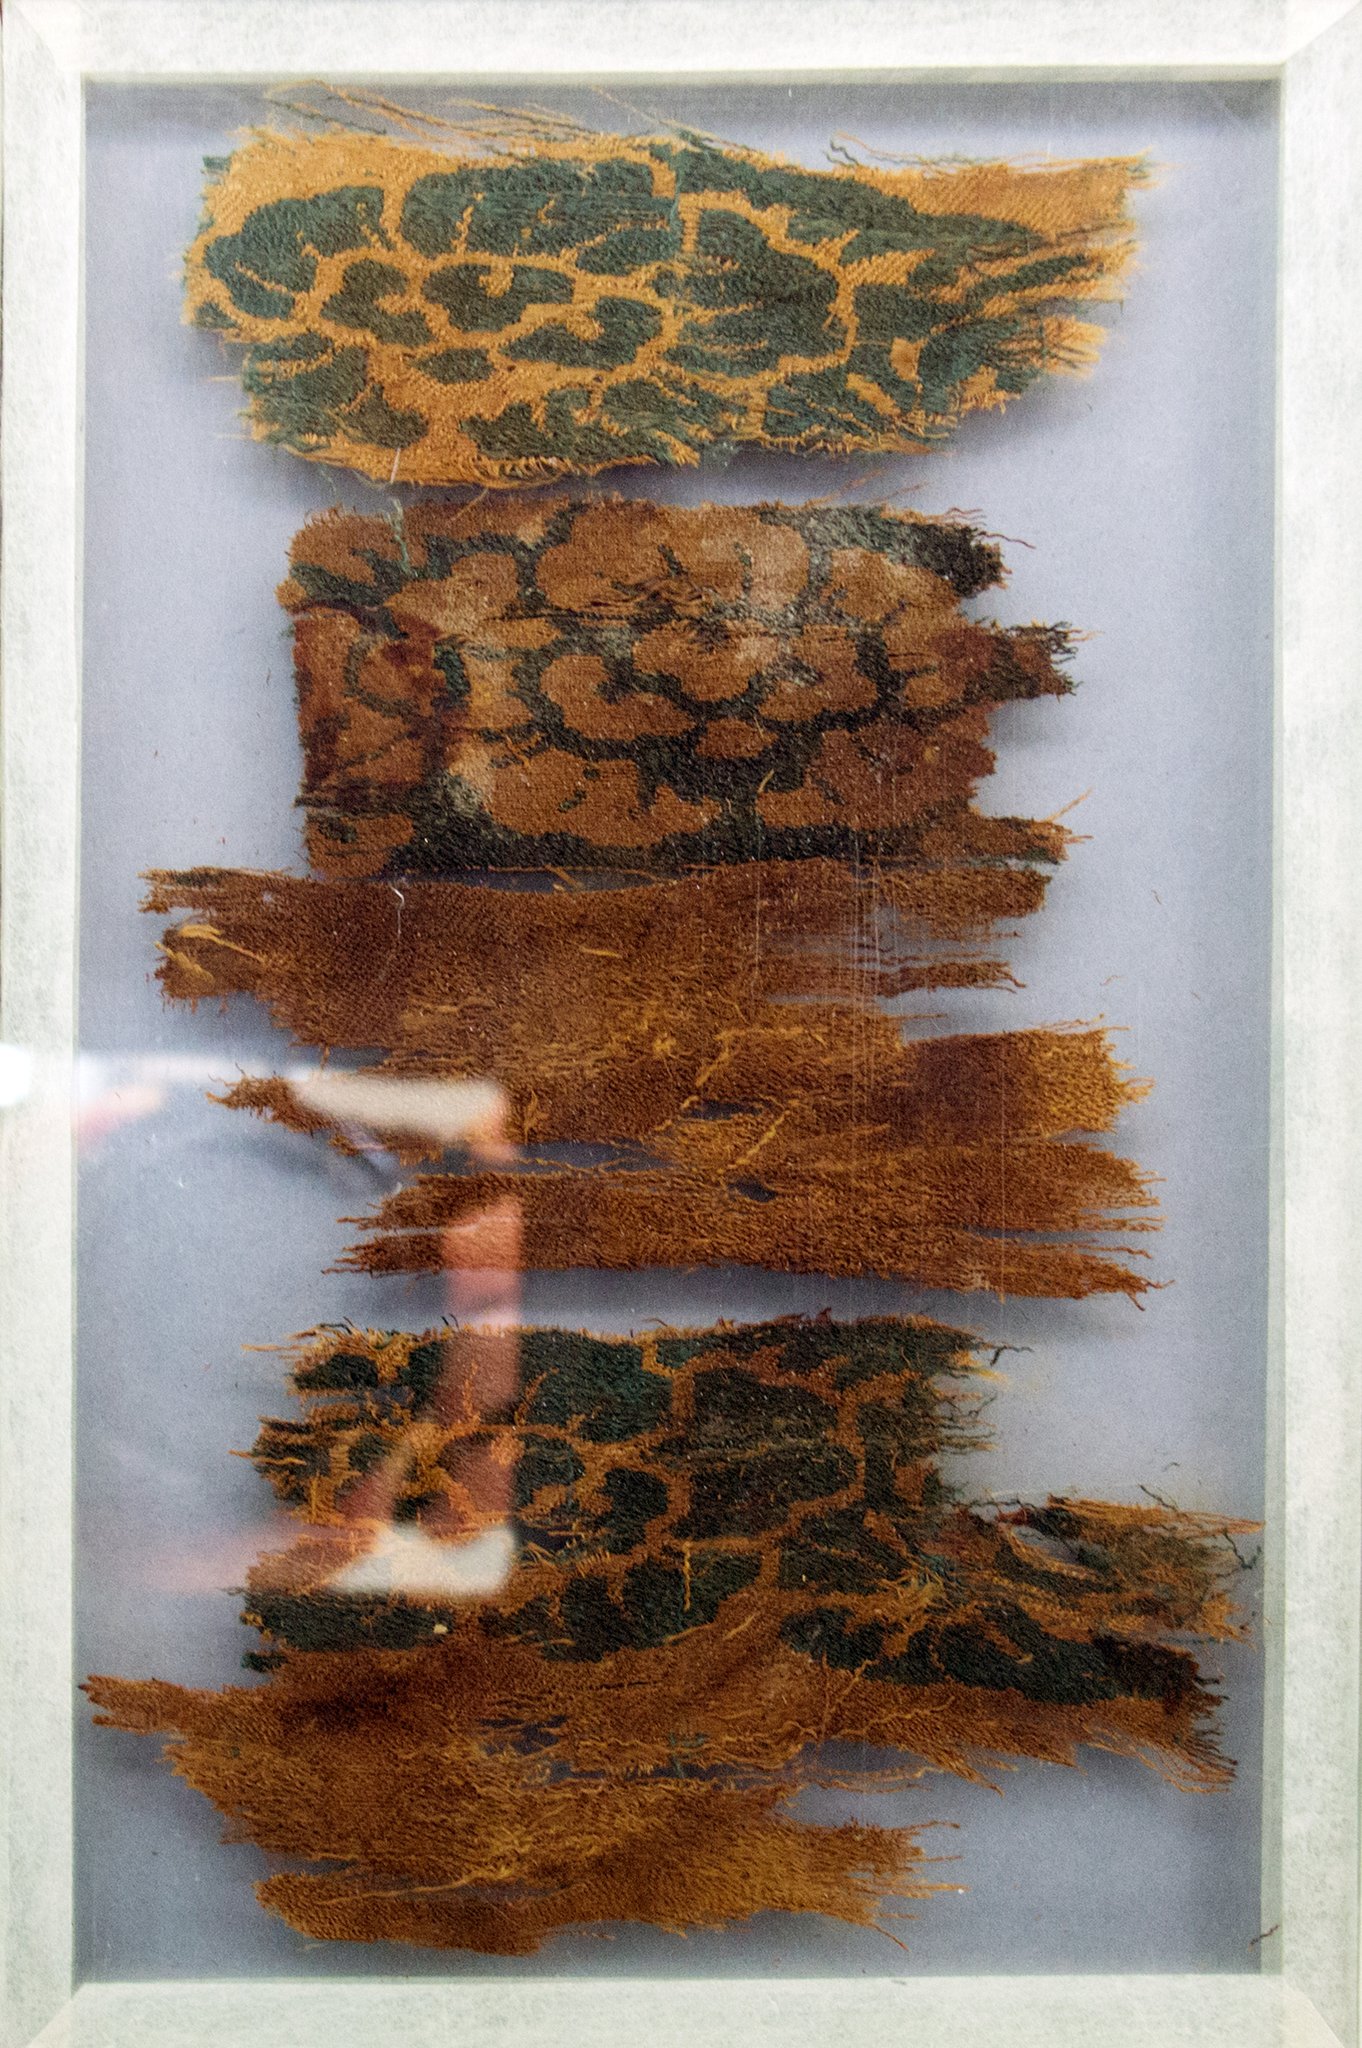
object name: fragment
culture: japanese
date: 701-800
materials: silk